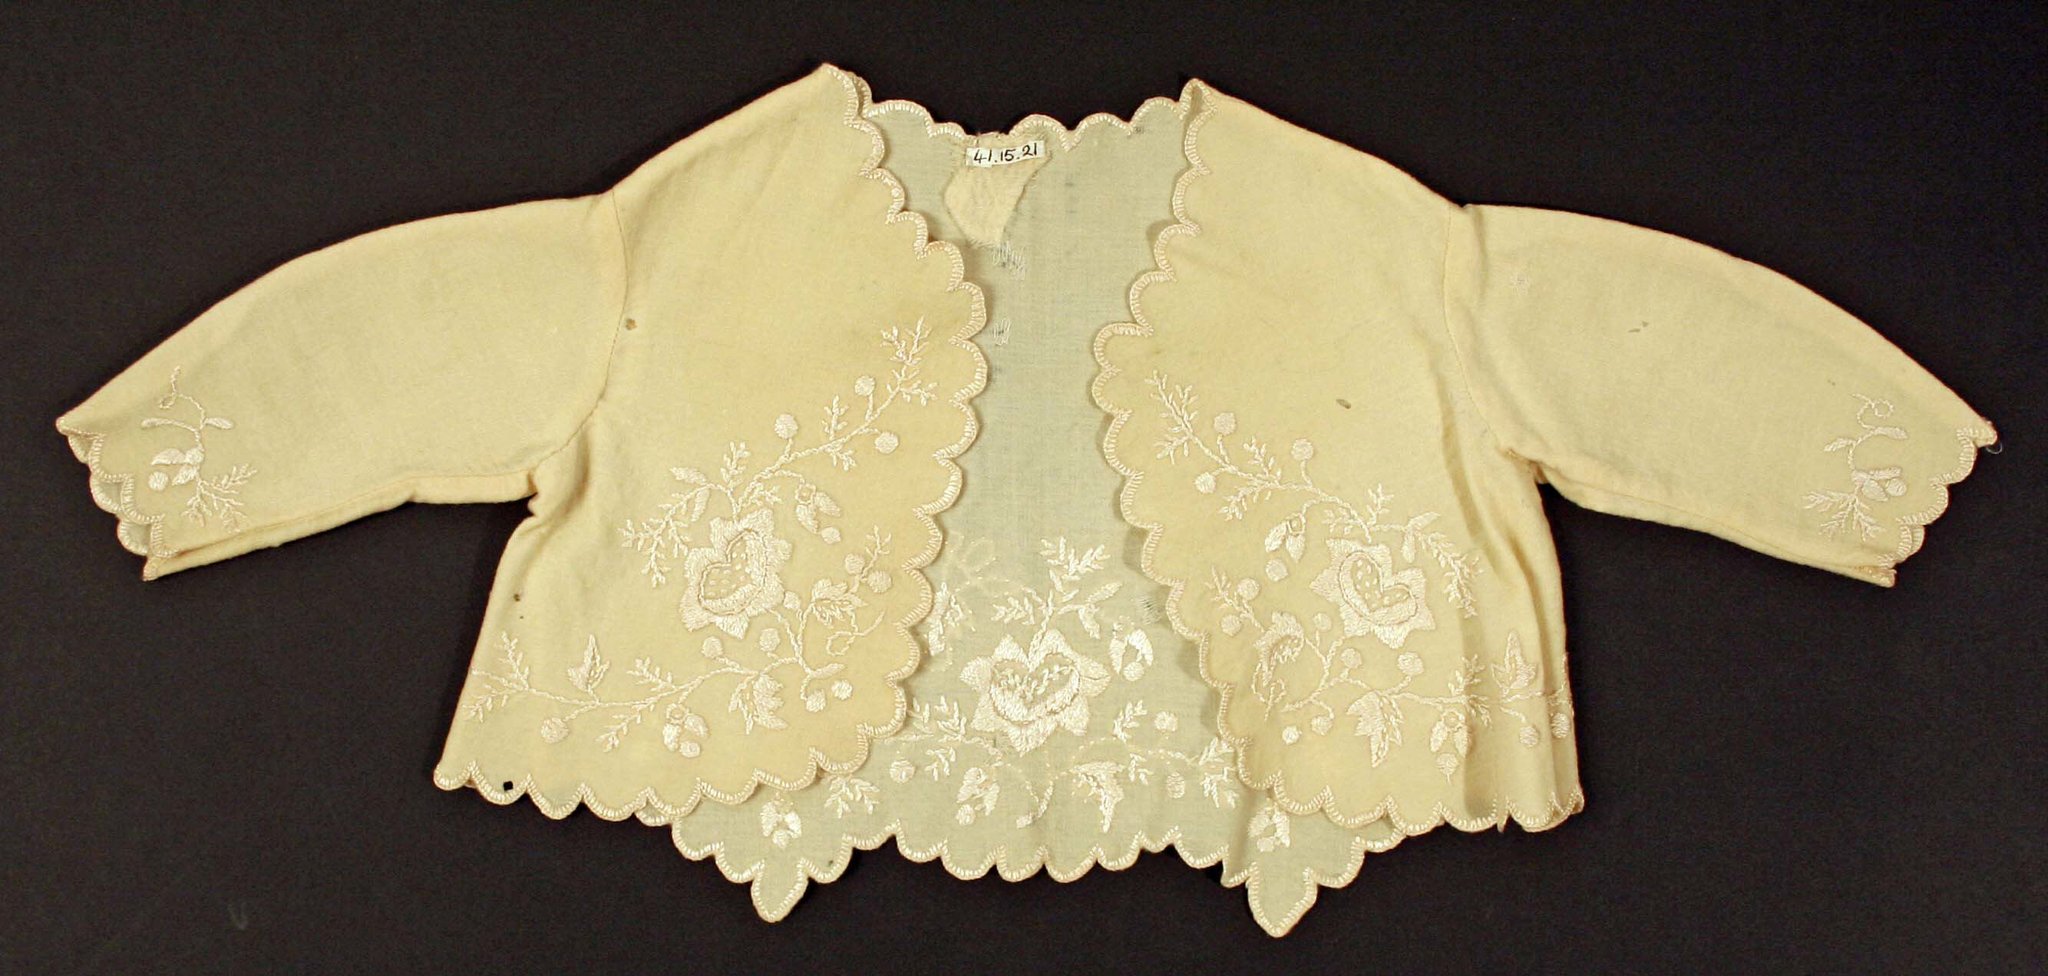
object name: jacket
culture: american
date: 1876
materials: silk